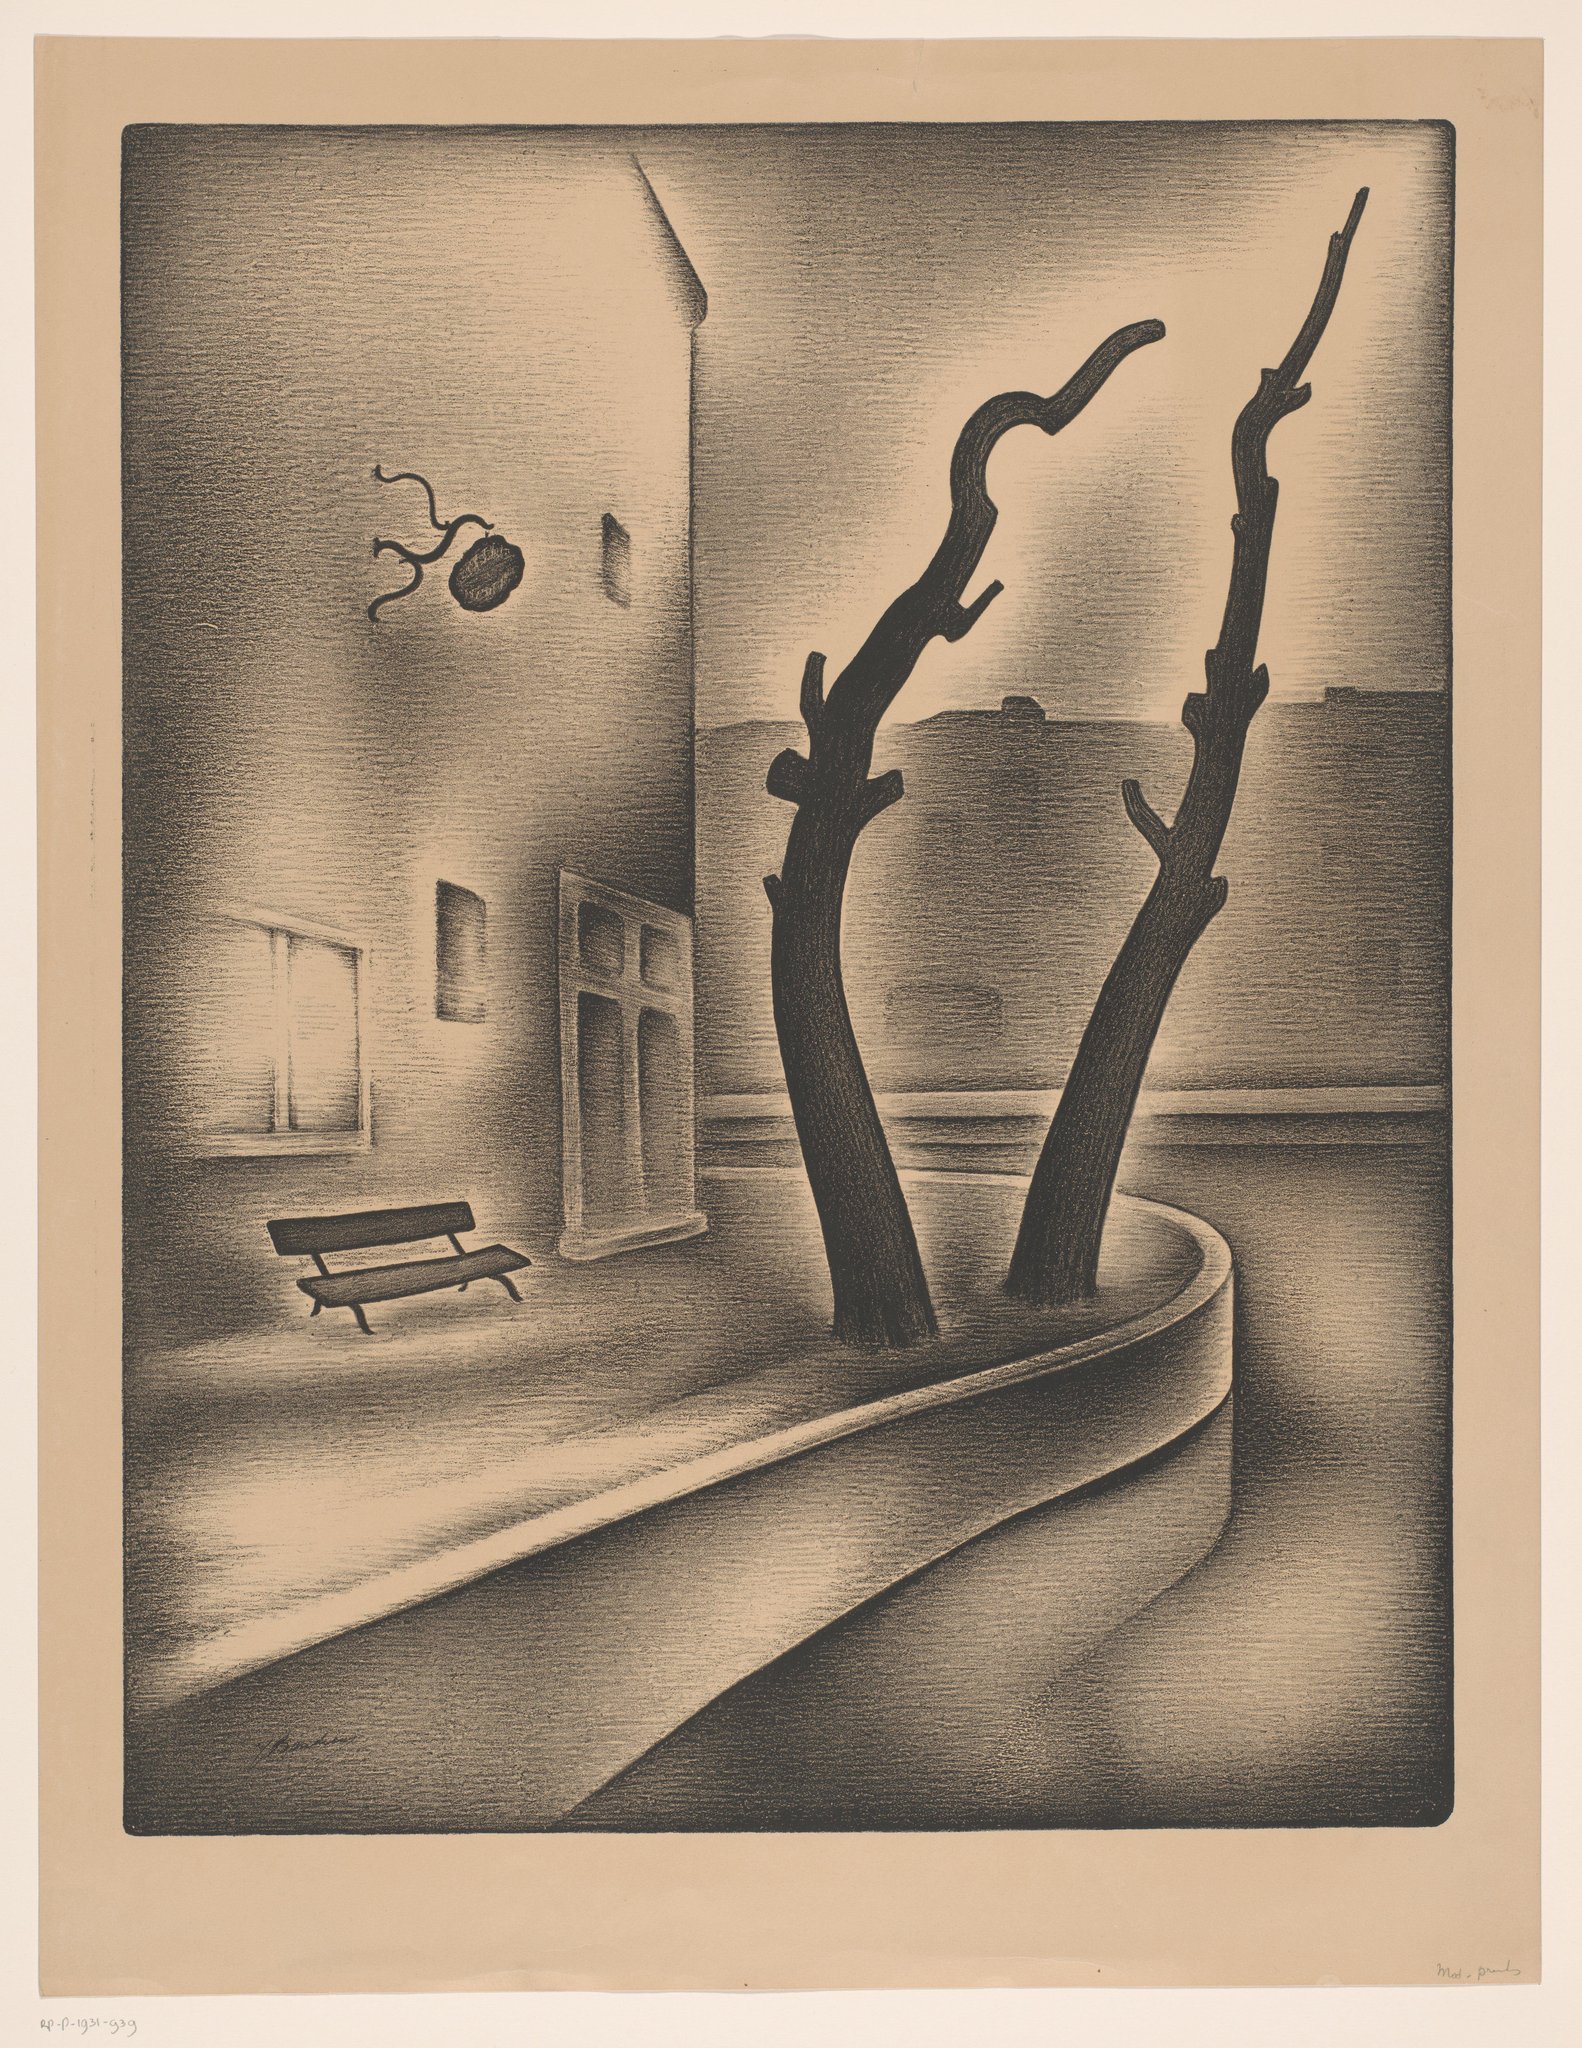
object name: print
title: Hoek van een gracht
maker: jacob bendien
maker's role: draughtsman, print maker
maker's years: 1890-1933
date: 1900-1931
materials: paper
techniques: lithograph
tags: bench, trees, canals, waters (in city)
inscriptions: inscription: ‘Mod. Prents’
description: Links een hoekhuis met een bankje. Op de hoek aan het water twee bomen.